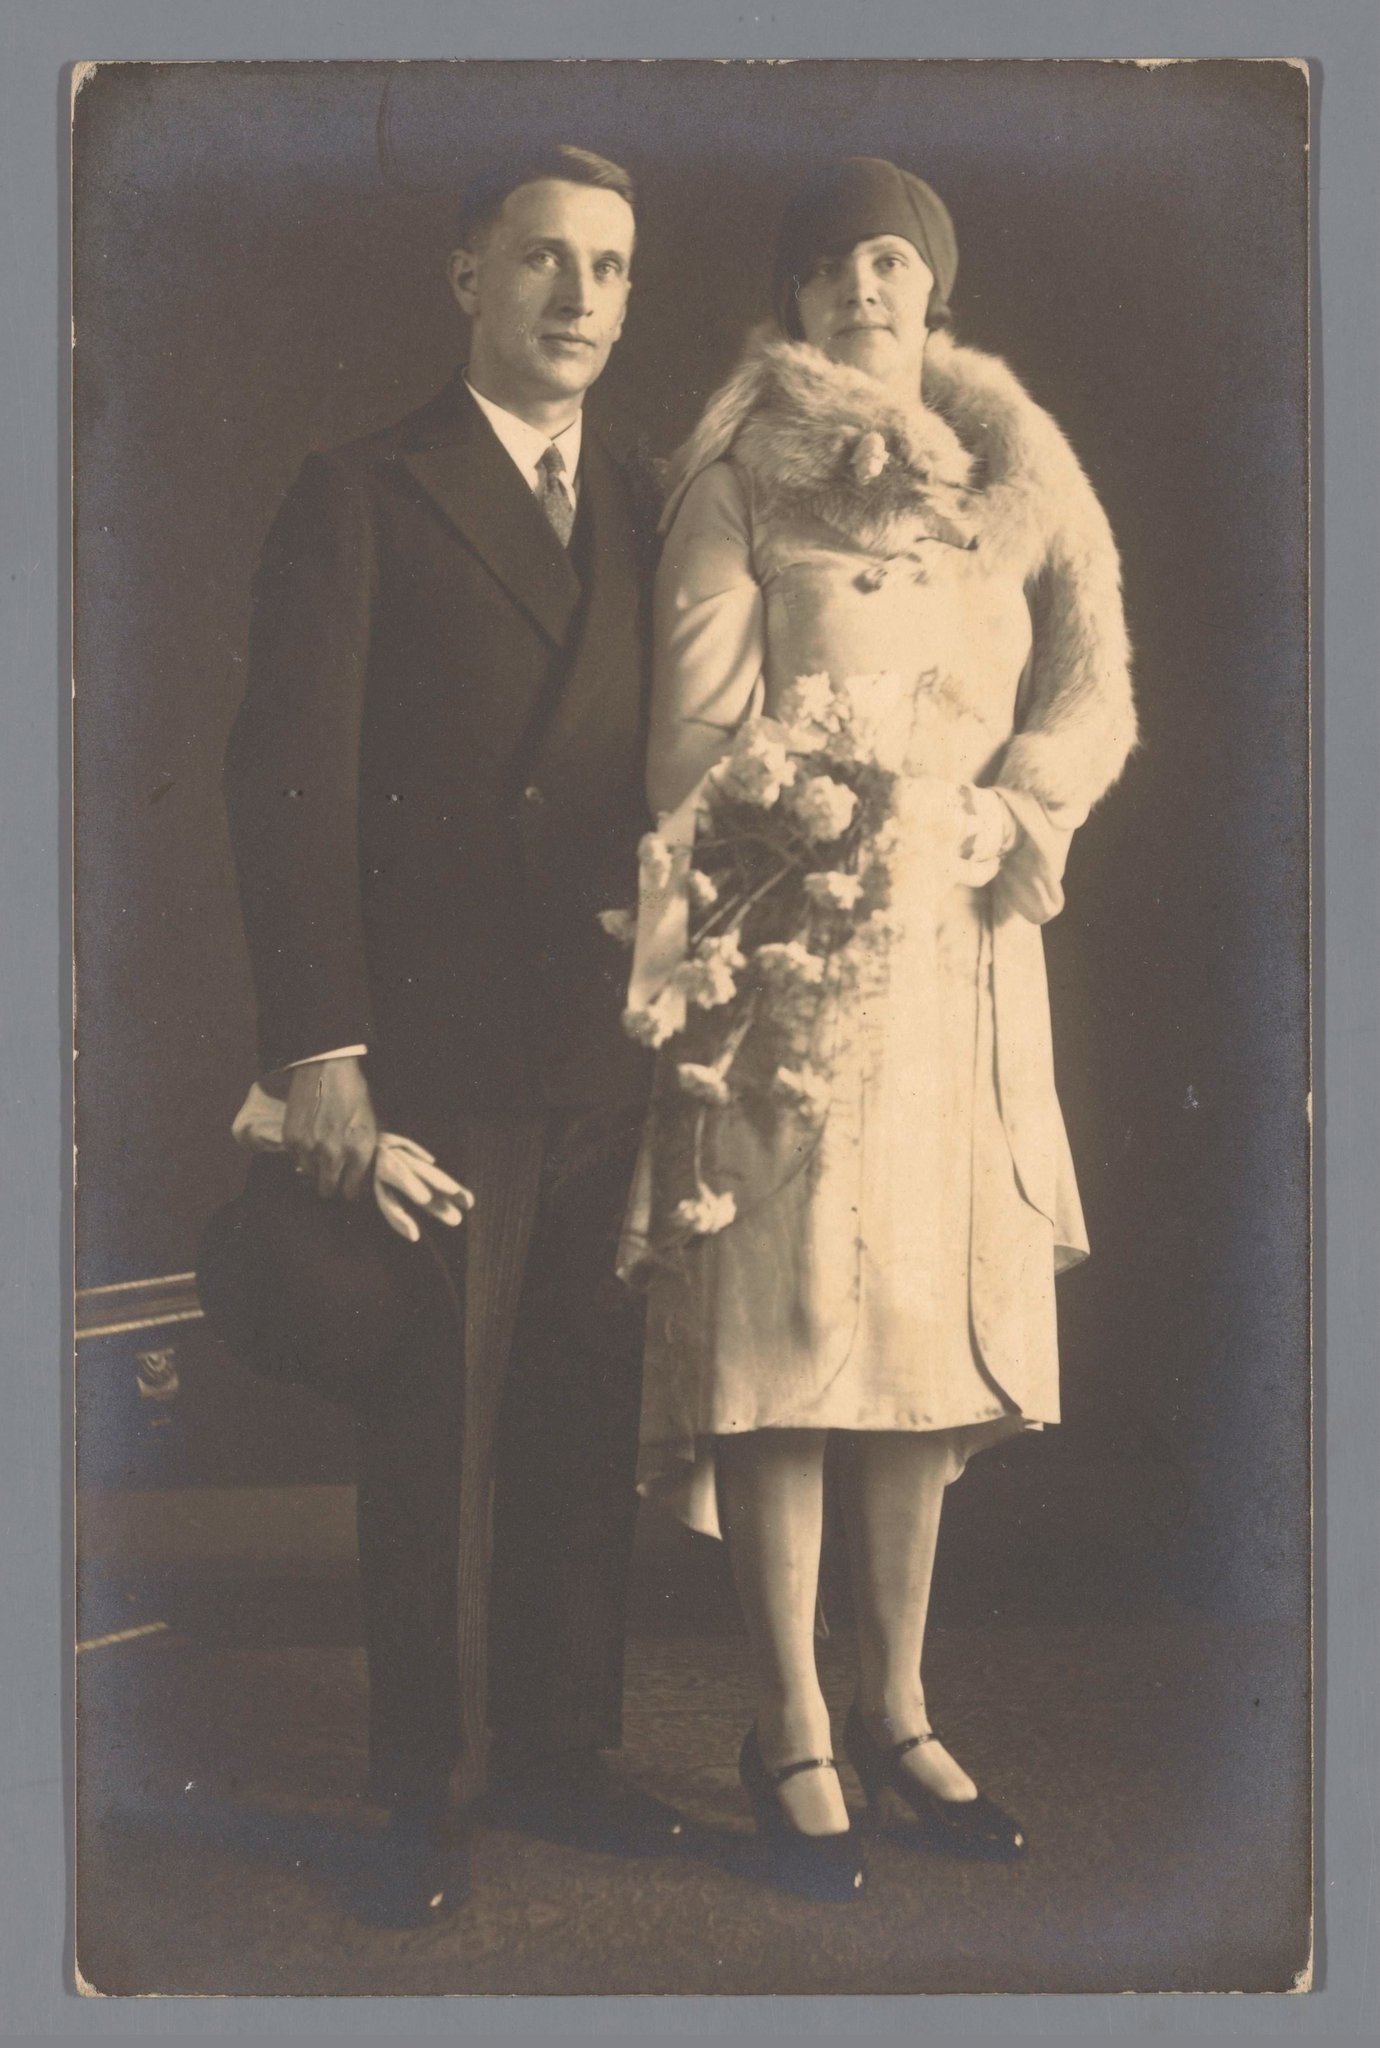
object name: photograph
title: Portret van een onbekend bruidspaar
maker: Anonymous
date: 1900-1940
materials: photographic support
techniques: gelatin silver print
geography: europe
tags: bride and groom in wedding-dress